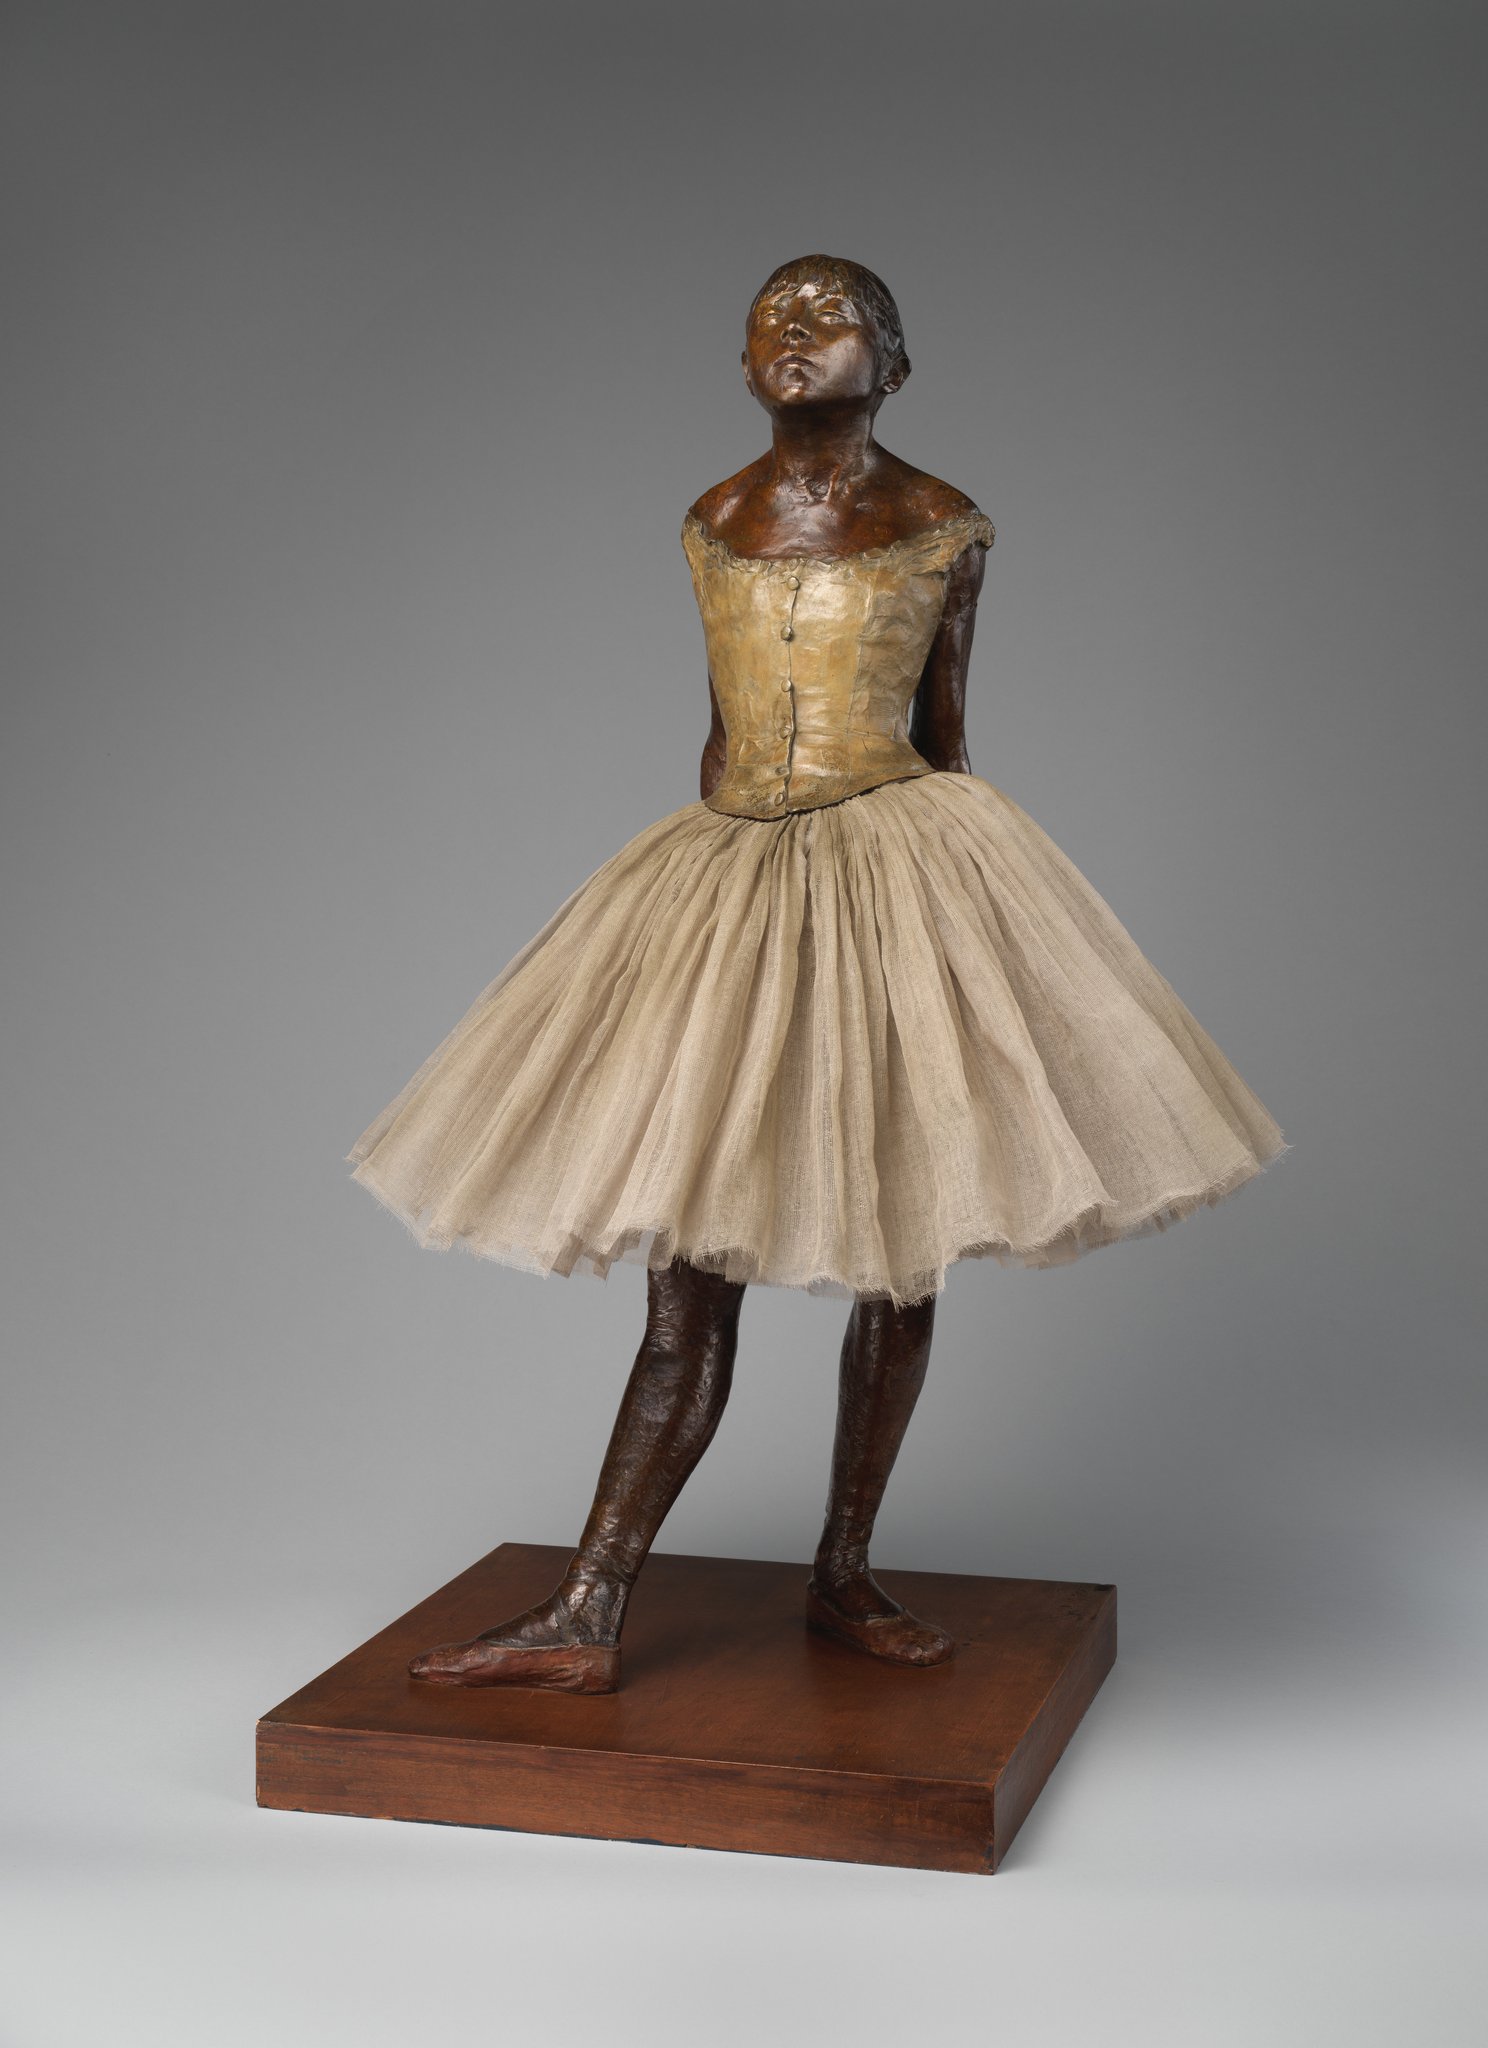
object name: statue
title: The Little Fourteen-Year-Old Dancer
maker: edgar degas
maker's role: artist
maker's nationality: french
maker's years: 1834-1917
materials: bronze, cotton, silk, wood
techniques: tinting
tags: girls,dancers,ballet